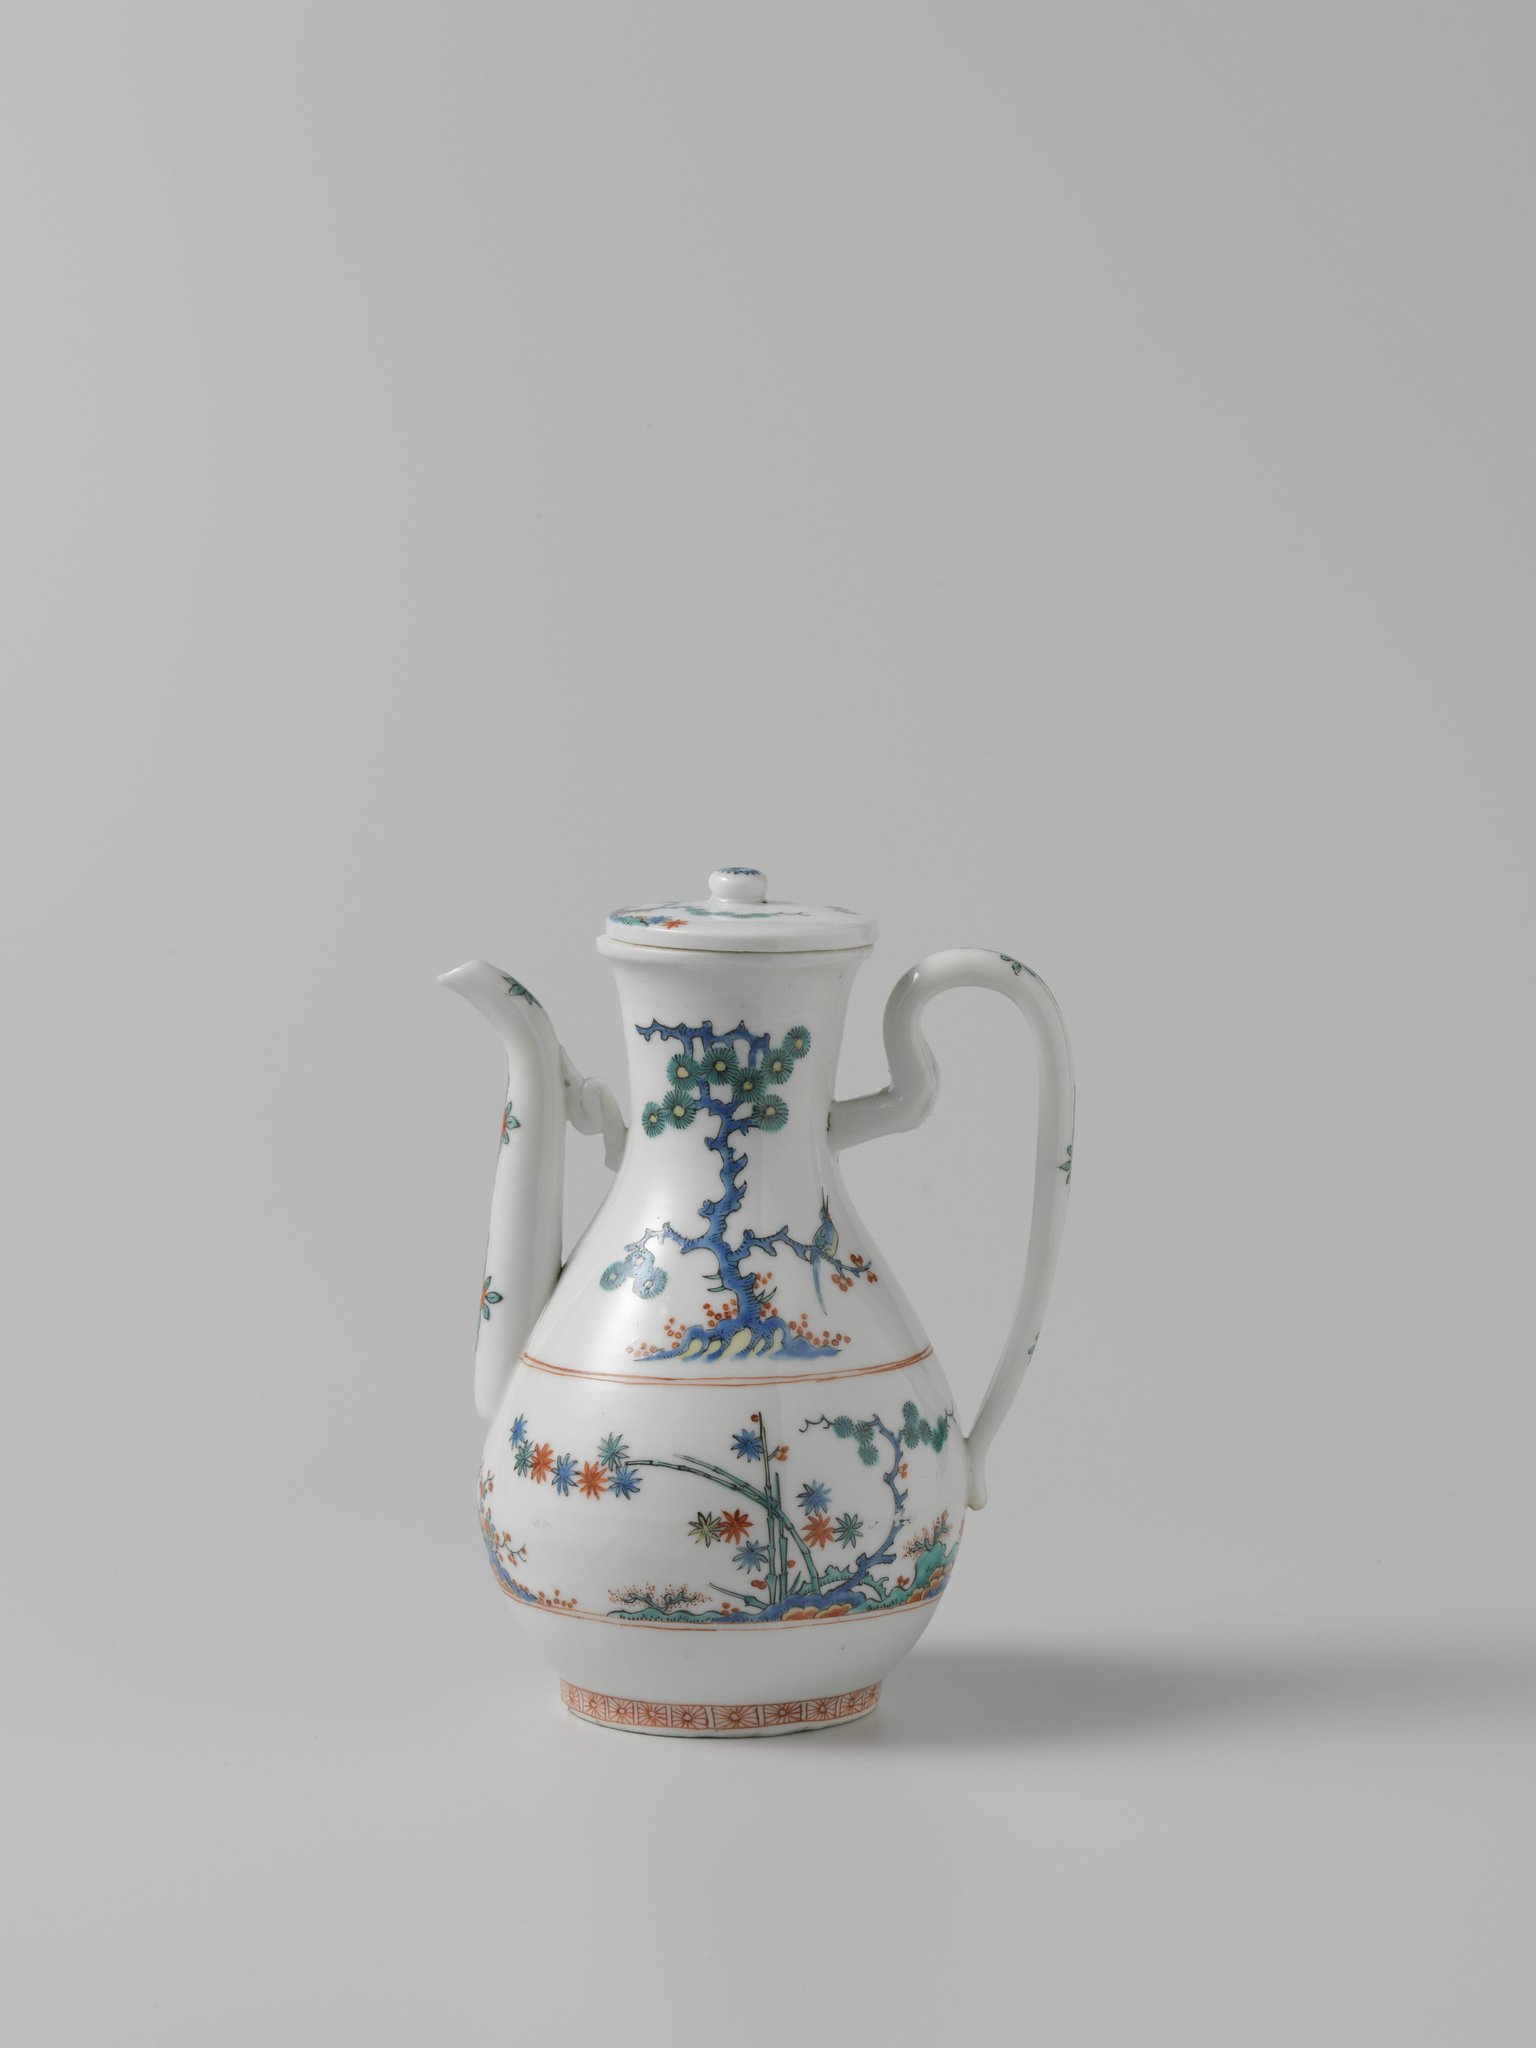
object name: lid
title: Cover of ewer with the 'three friends of winter'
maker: Anonymous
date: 1700-1724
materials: glaze, gold, paint, porcelain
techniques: firing, gilding, turning, vitrification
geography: europe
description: Jug with lid. Blanc de Chine, c. 1700 - 1750.